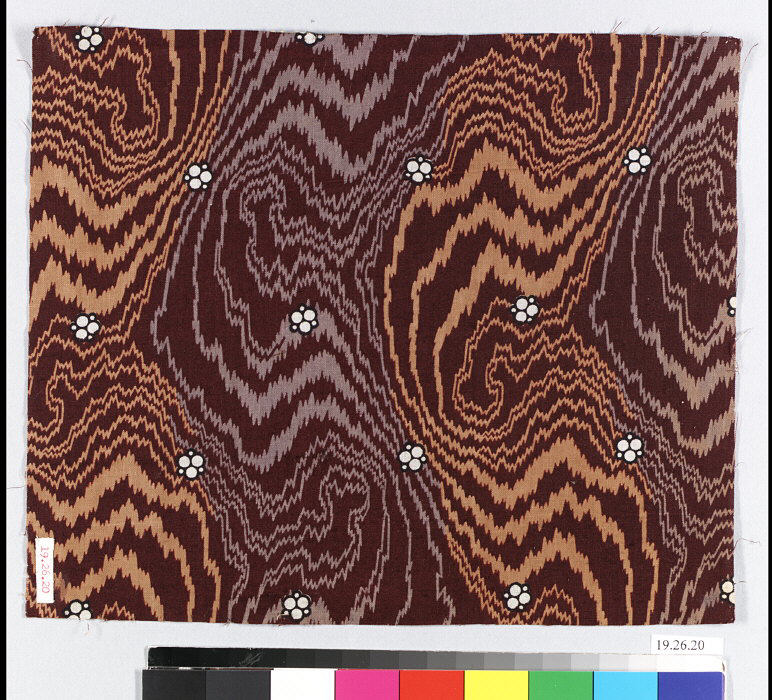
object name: sample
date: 1840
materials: cotton